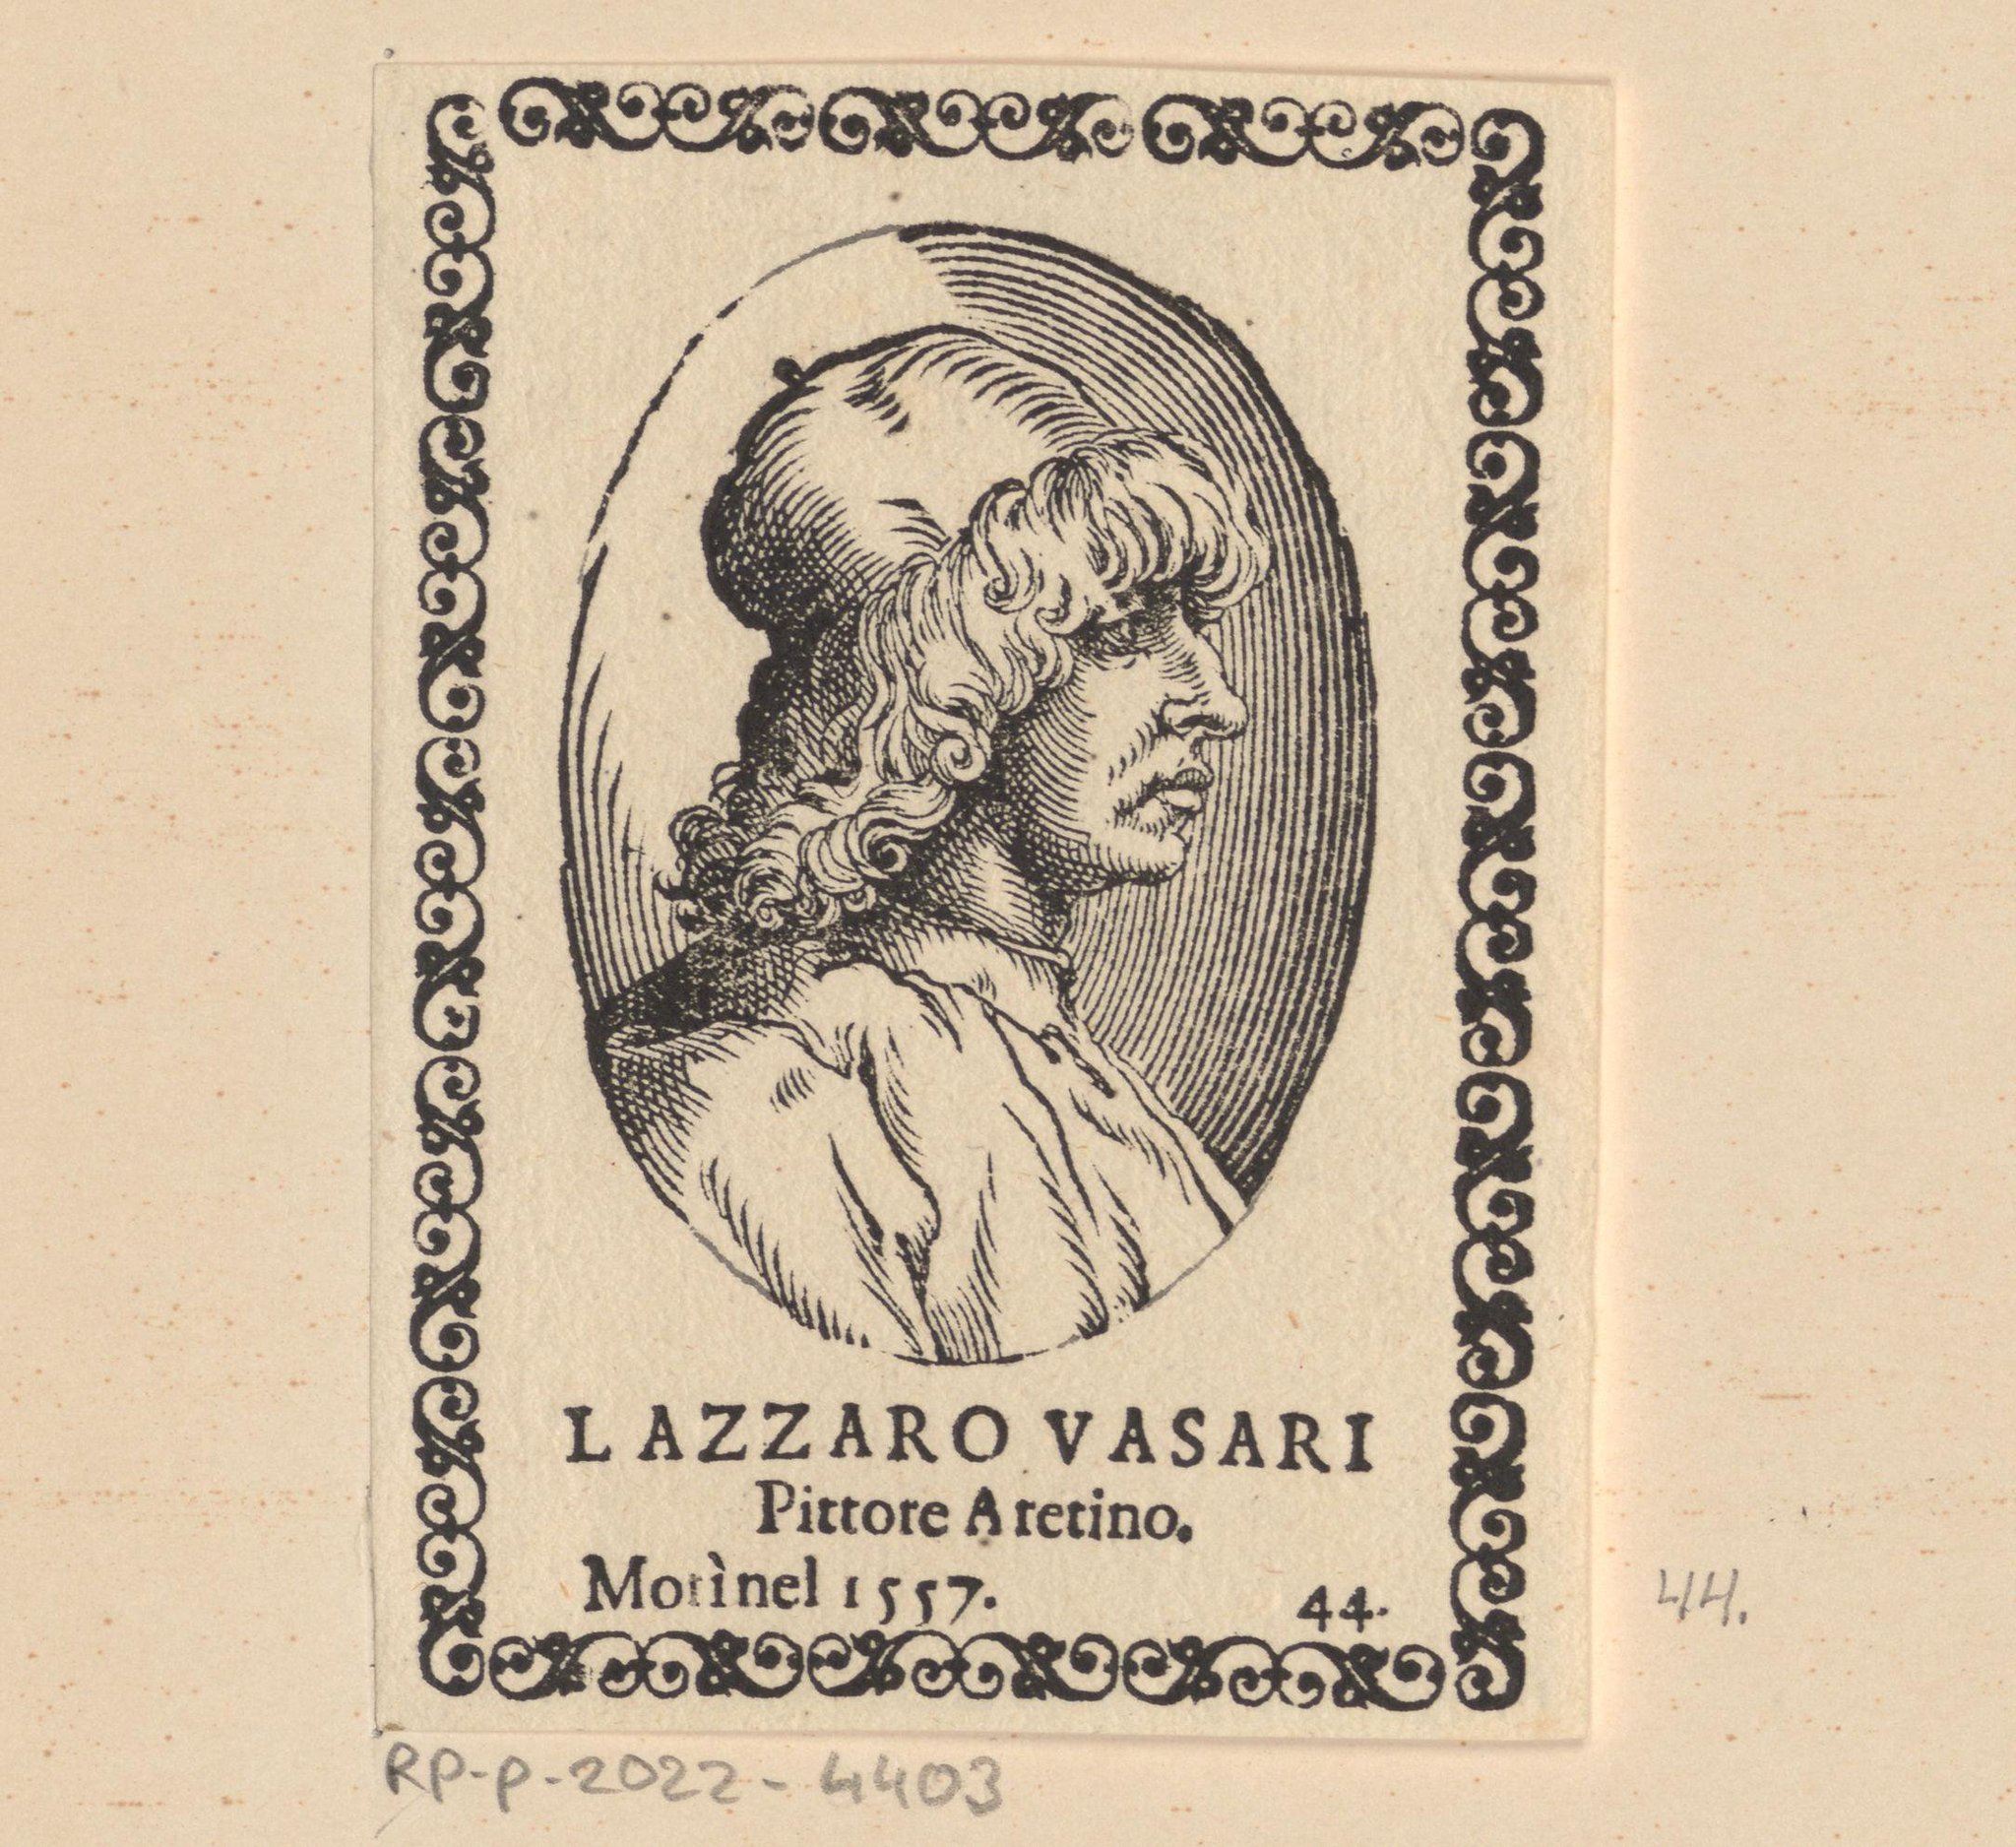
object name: print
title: Portret van Lazzaro Vasari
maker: cristoforo coriolano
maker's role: print maker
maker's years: 1540-1610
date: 1568-1650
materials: ink, paper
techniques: letterpress printing, pen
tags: painter, historical persons, portrait, self-portrait of painter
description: Prent komt uit een editie van Vasari's 'Vite'. Prent met een andere omlijsting is gebruikt in de editie uit 1568: Vasari, Giorgio. Le vite de' piu eccellenti pittori scultori, e architettori. Florence: Filippo Giunta, 1568. En mogelijk in de editie uit 1647.